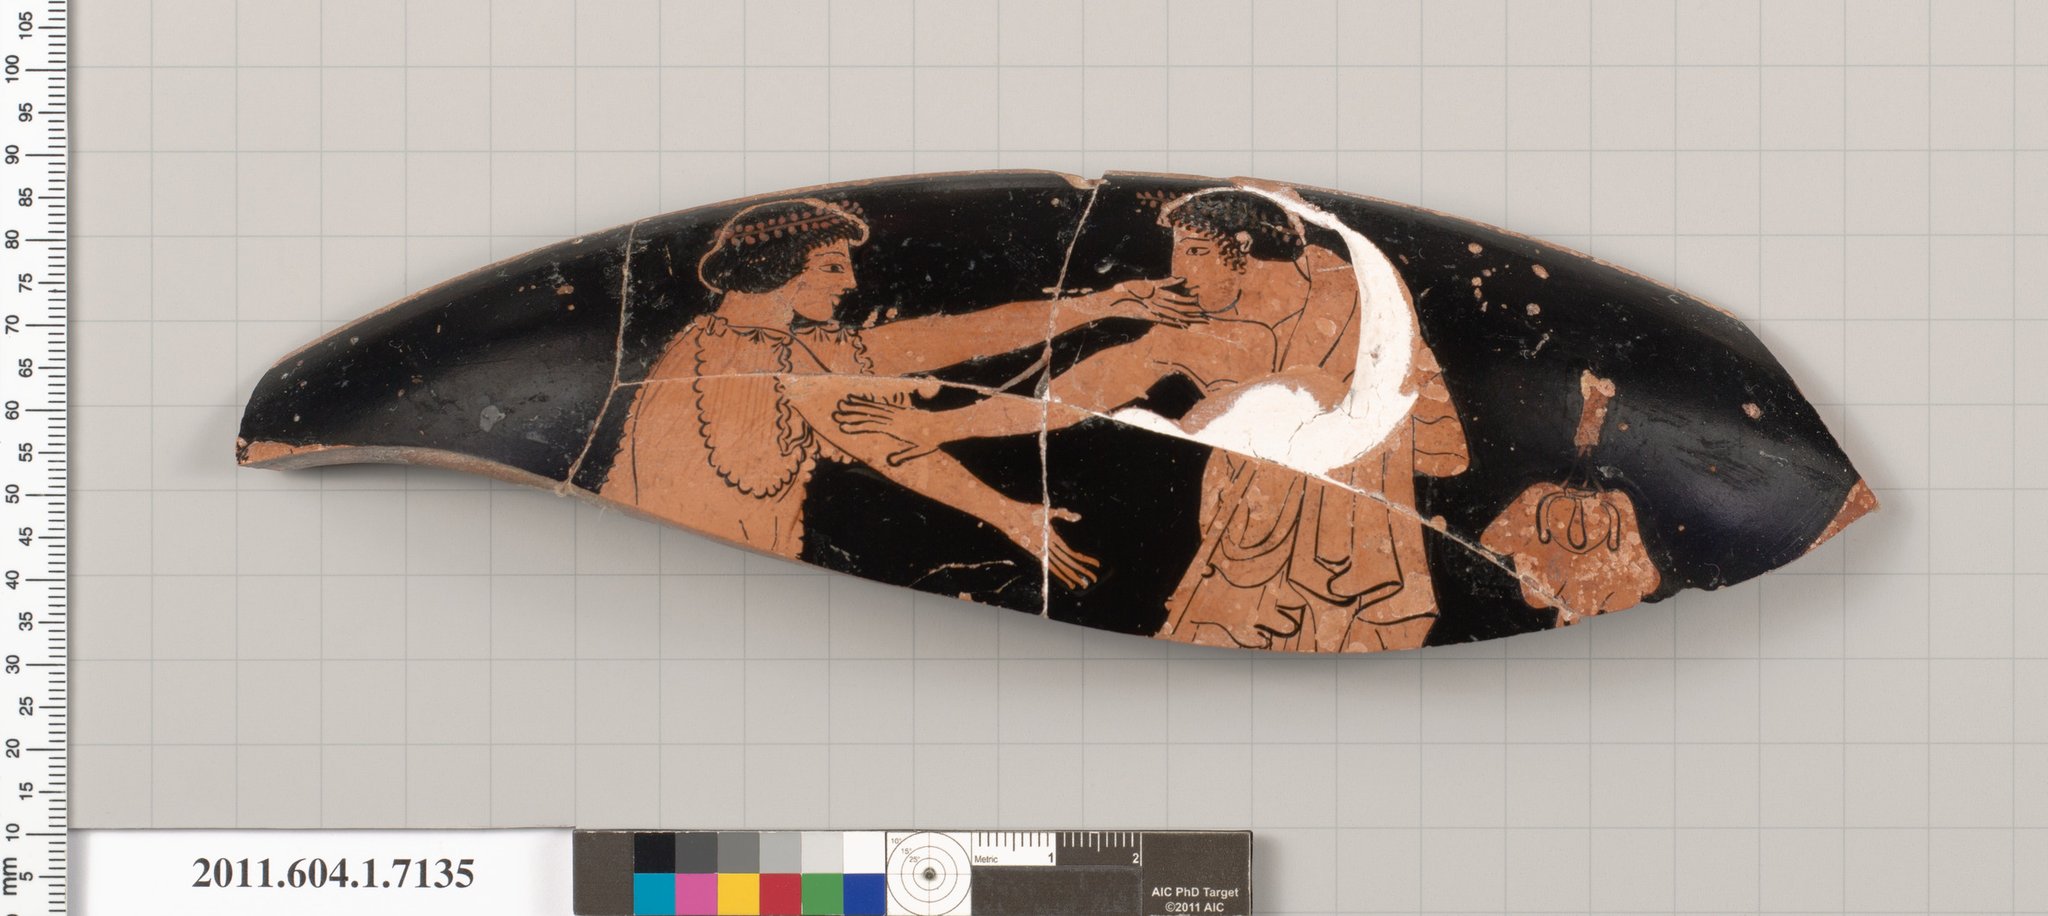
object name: kylix fragment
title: Terracotta rim fragment of a kylix (drinking cup)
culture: greek, attic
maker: makron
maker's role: artist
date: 500-480 BCE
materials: terracotta